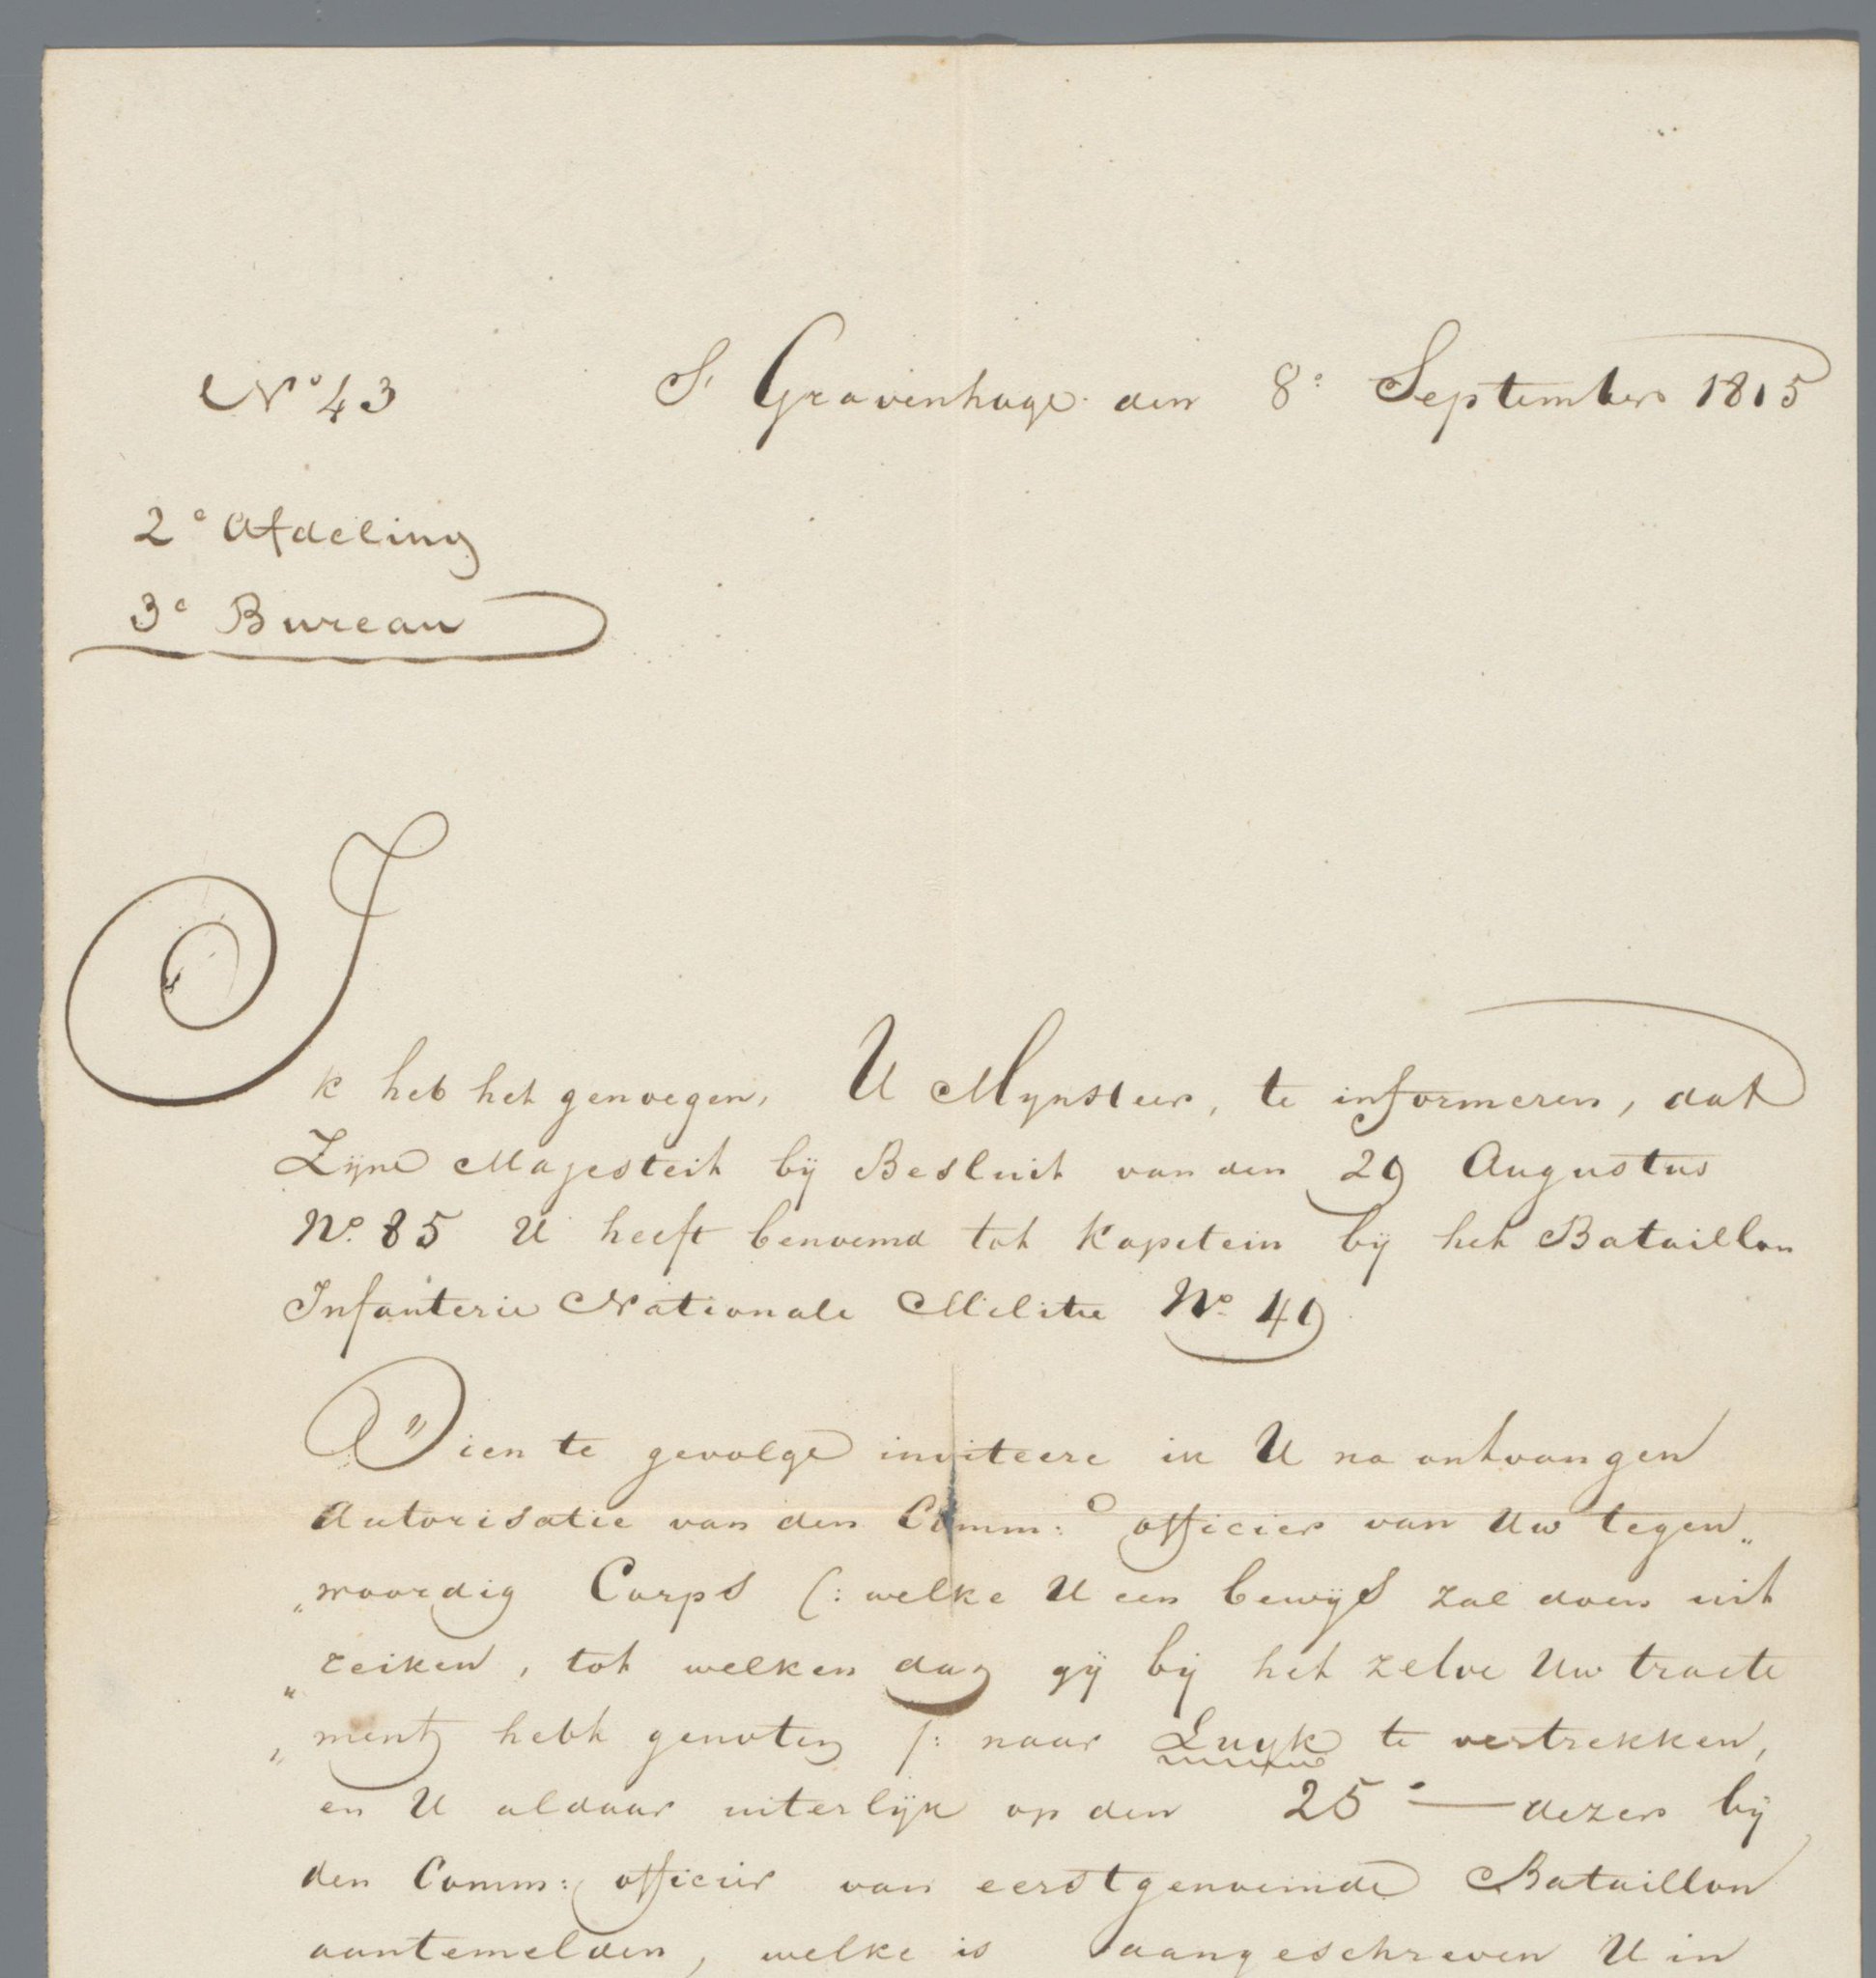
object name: letter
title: Benoeming van J.D.B. Wilkens als kapitein bij het Bataljon Infanterie Nationale Militie No. 41, 8 september 1815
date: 1815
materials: ink, paper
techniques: handwriting, pen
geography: netherlands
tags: amsterdam, military service, netherlands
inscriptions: number: ‘11198’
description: Onderdeel van een groep van documenten betreffende de staat van dienst, benoemingen, enz. van Luitenant Kolonel van de Infanterie J.D.B. Wilkens. Behorende bij de schenking van het geschilderde portret.